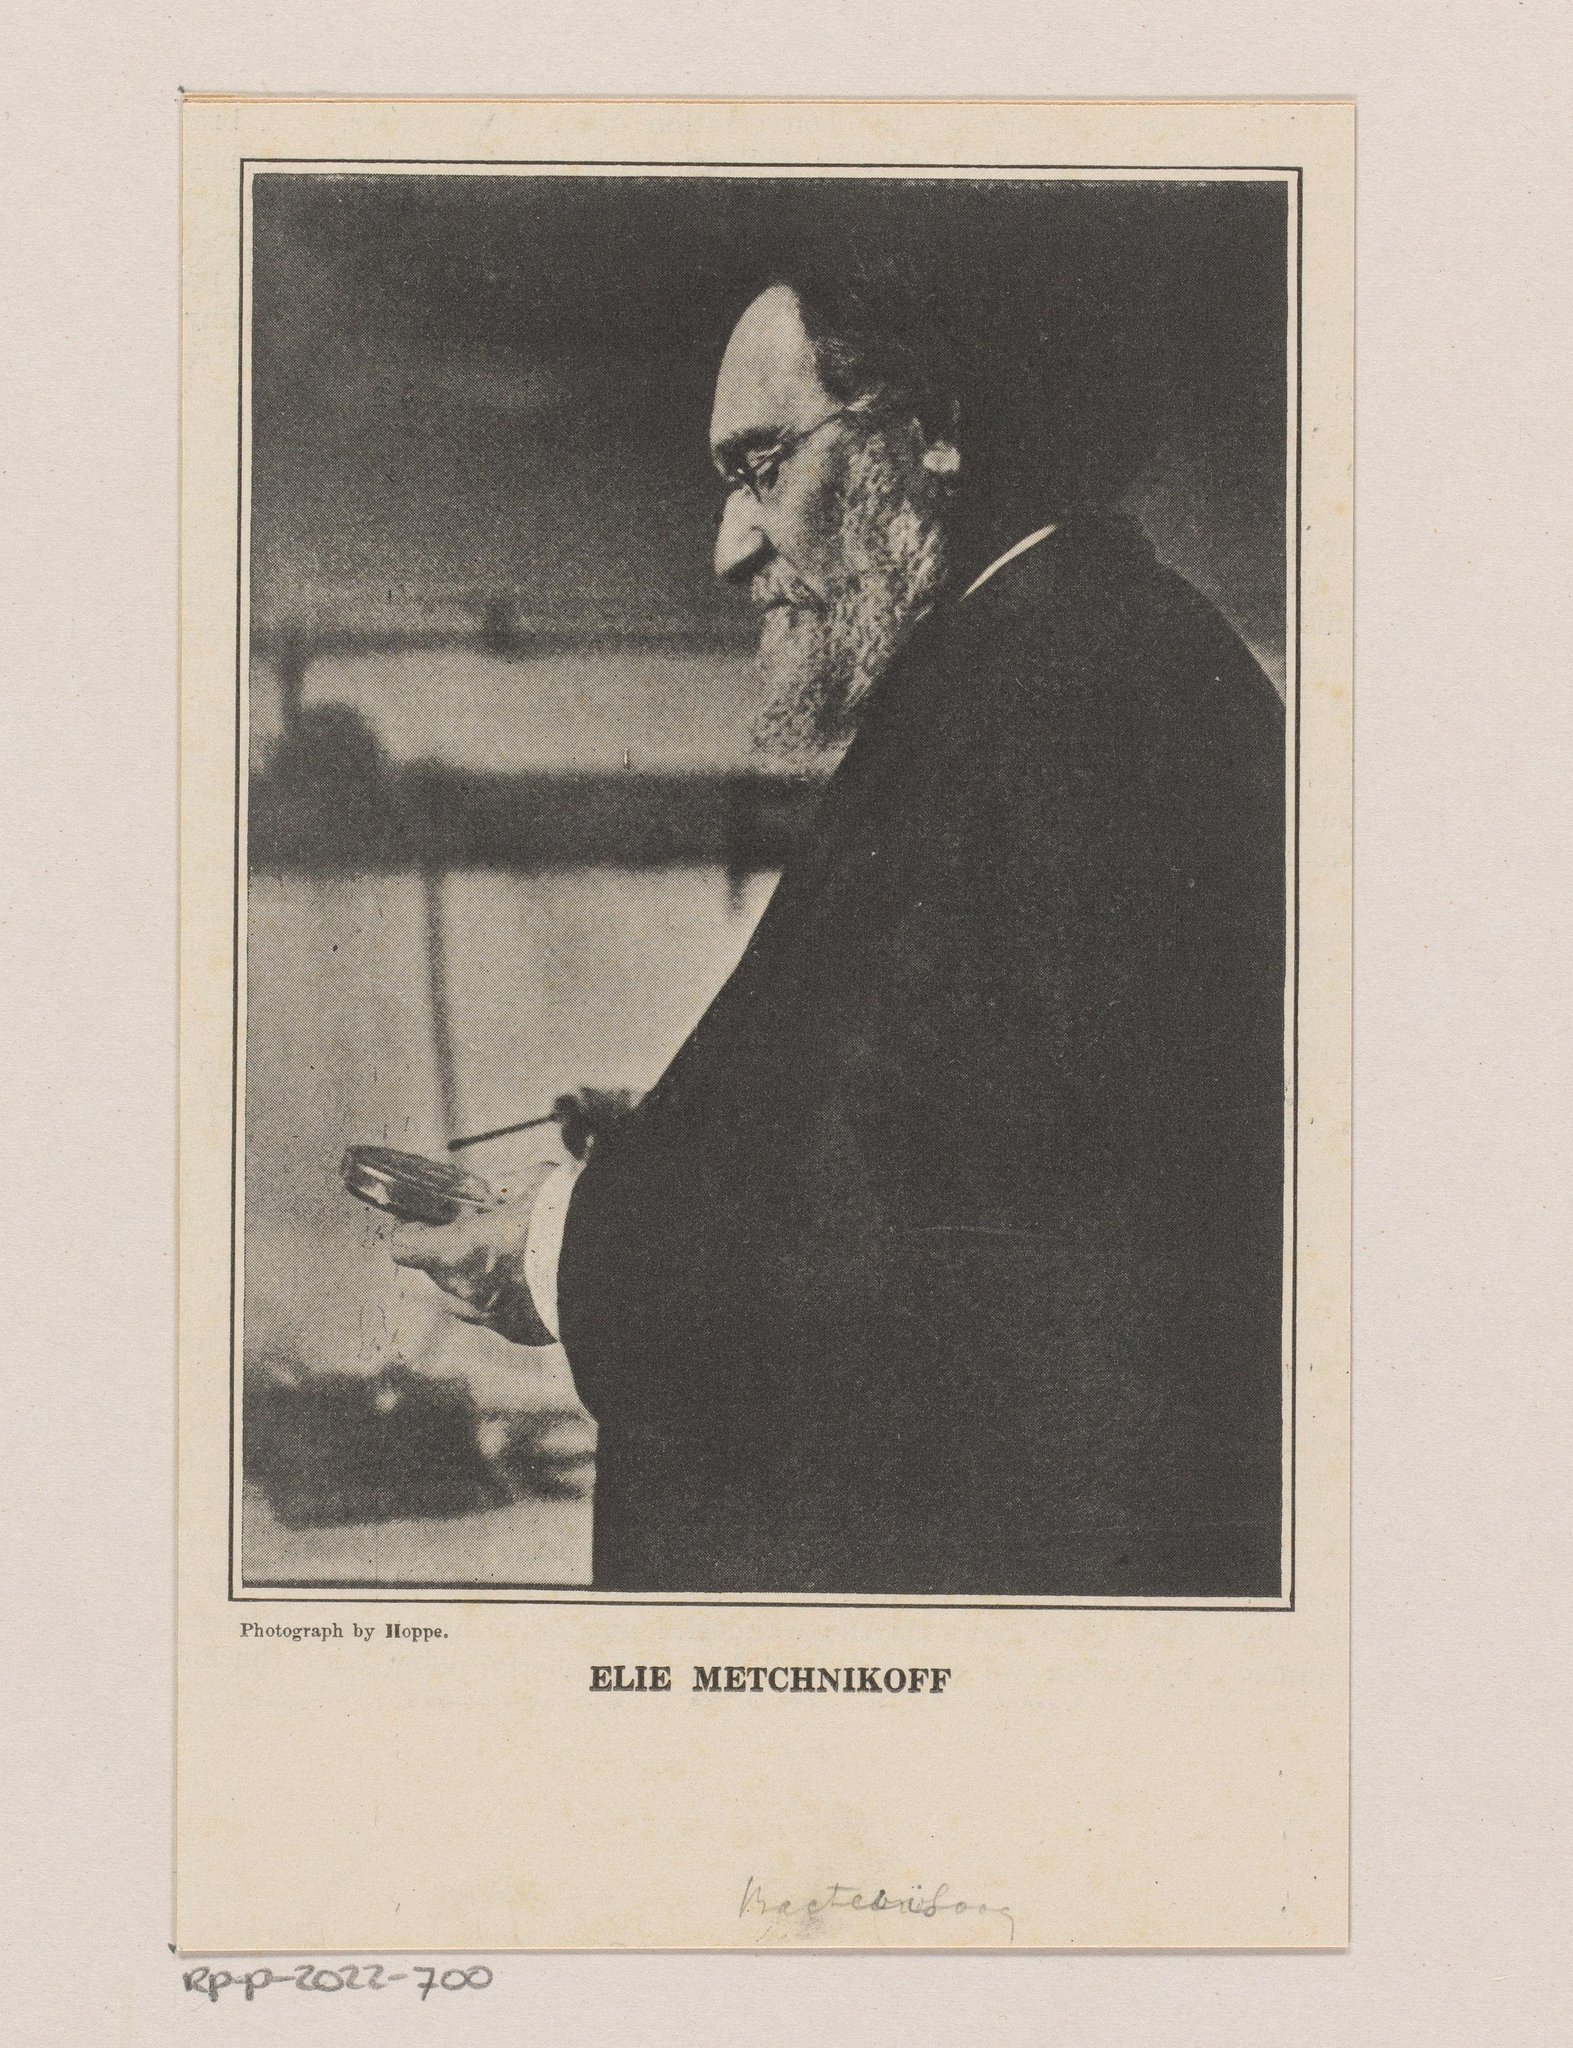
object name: photomechanical print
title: Elie Metchnikoff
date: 1882-1970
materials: paper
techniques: autotype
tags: paris, historical persons, biology (+ portrait of scholar, scientist)